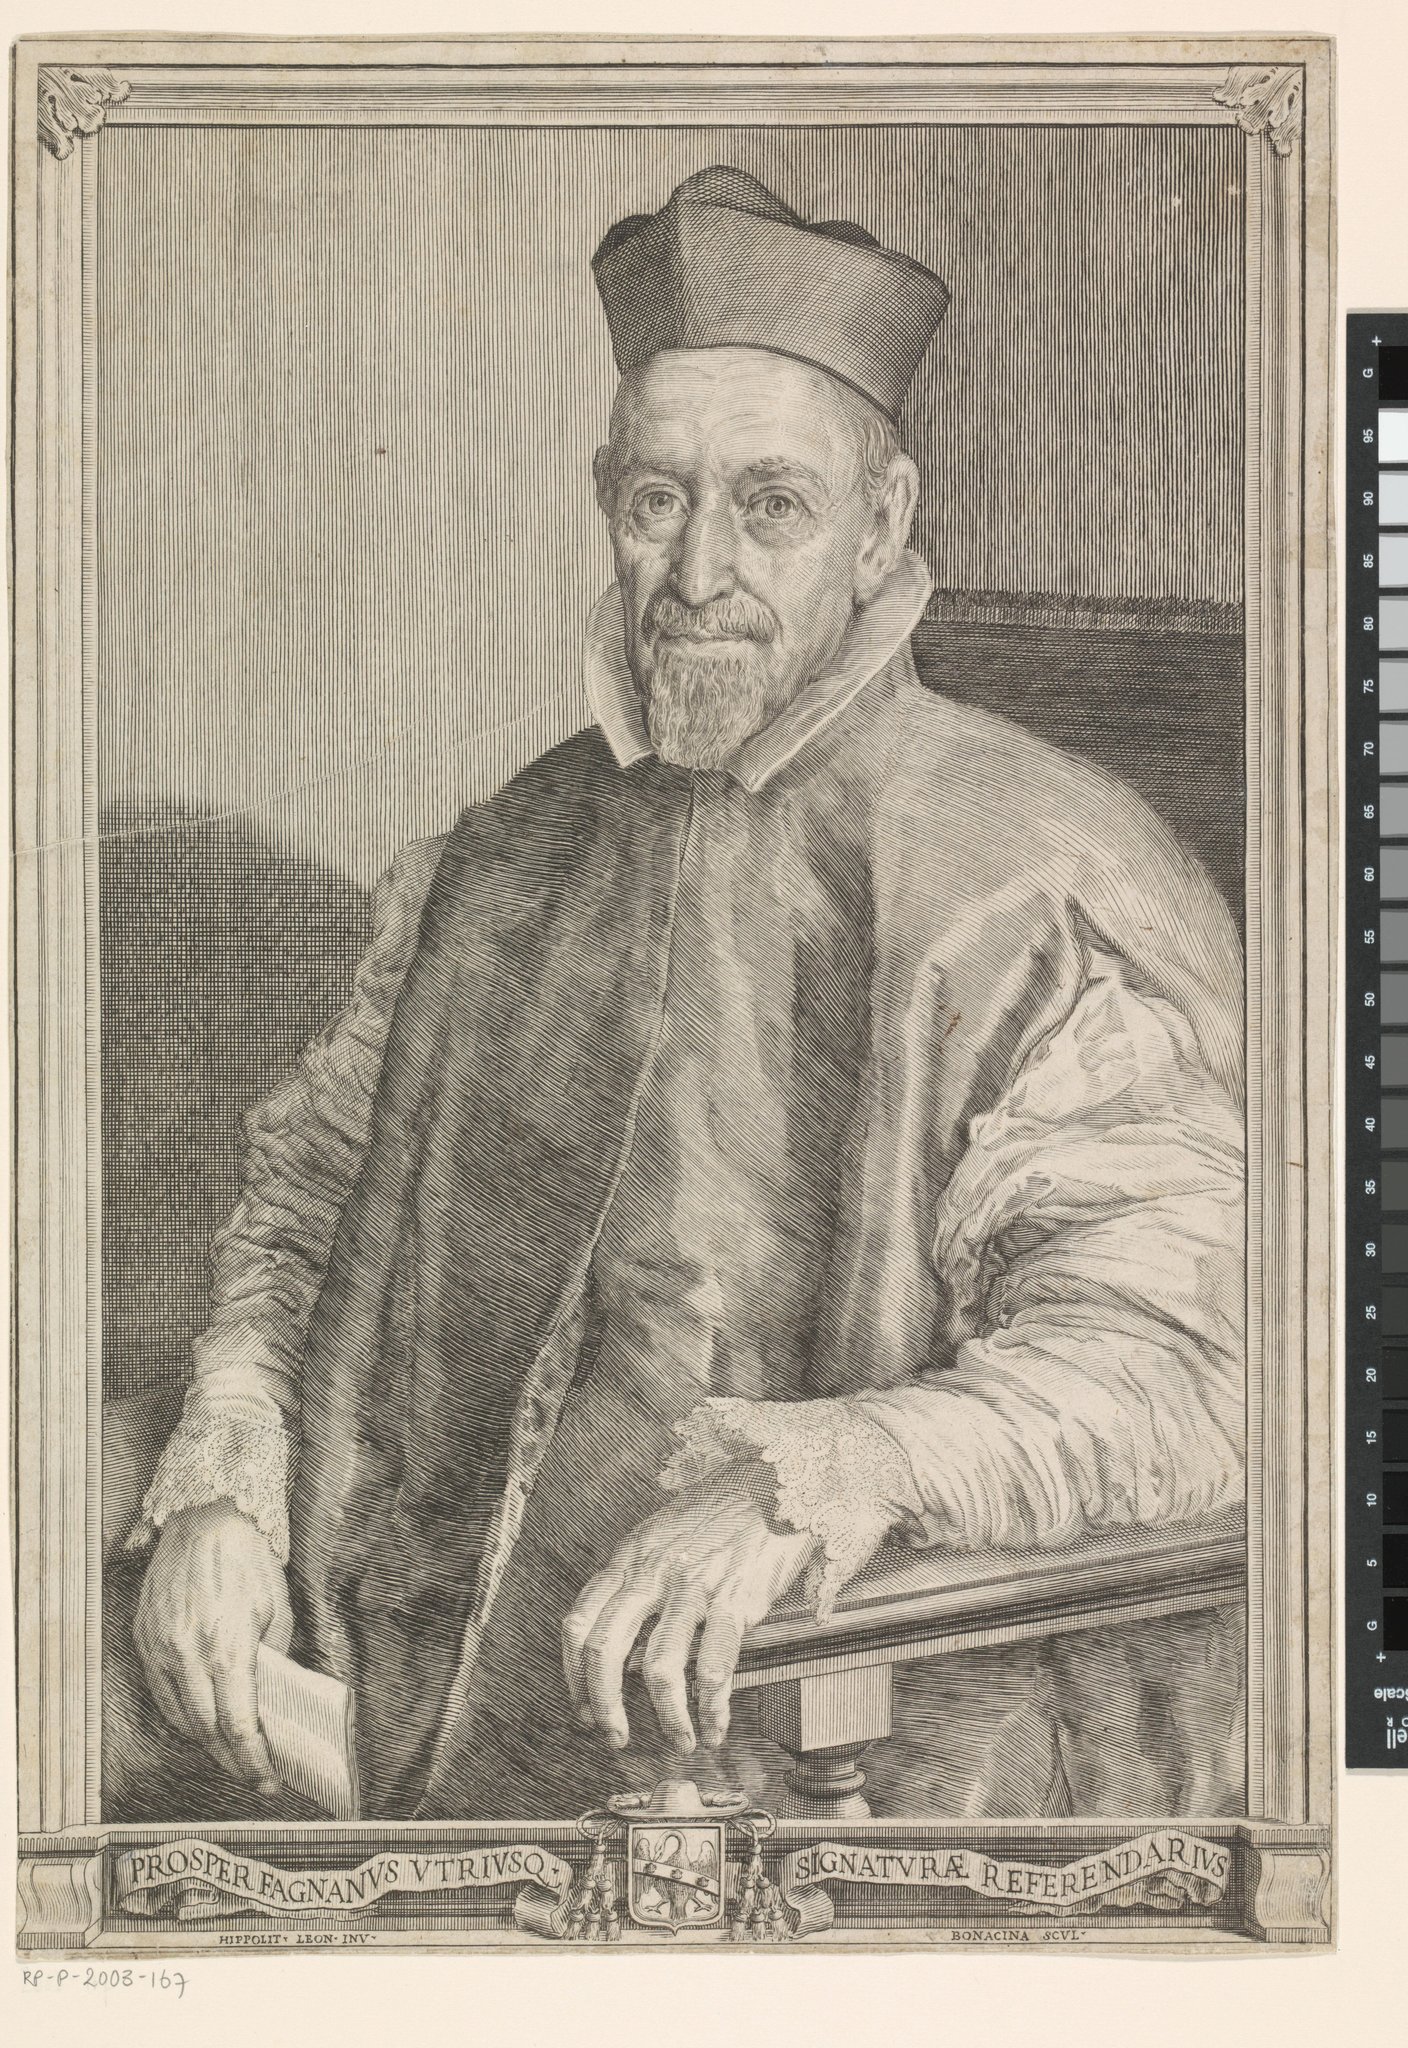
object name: print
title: Portret van kardinaal Prospero Fagnano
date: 1625-1669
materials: paper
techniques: engraving, etching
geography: italy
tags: cardinal, historical persons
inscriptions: collector's mark: Lugt 2228, collector's mark: Lugt 4030, collector's mark: Lugt 2760